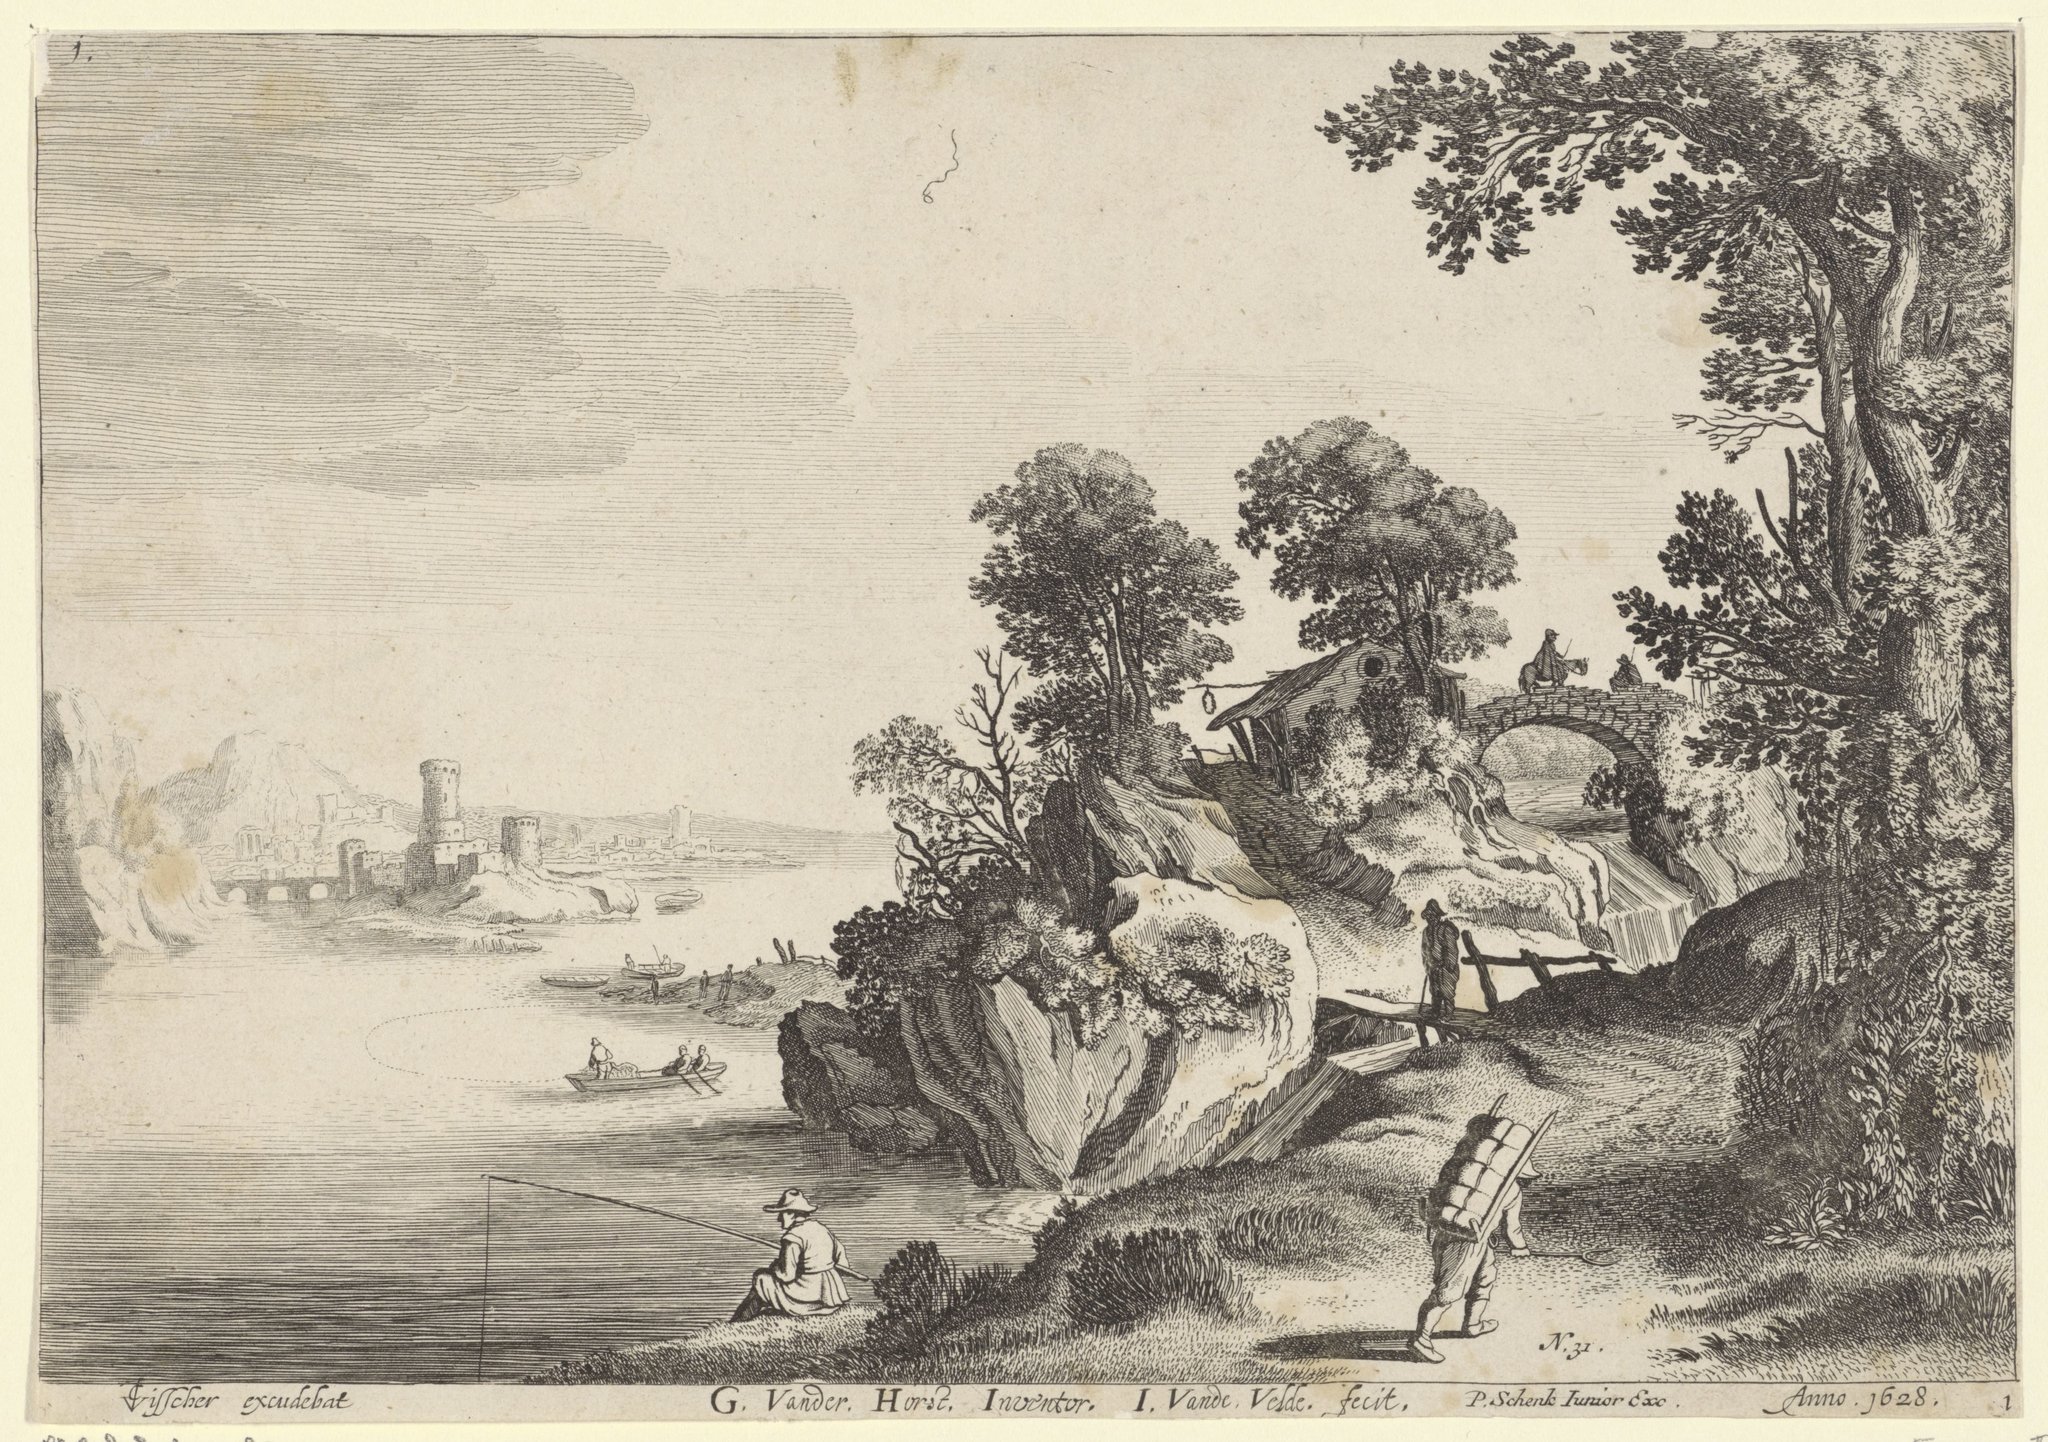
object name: print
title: Landschappen naar Gerrit van der Horst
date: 1628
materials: paper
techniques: etching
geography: northern netherlands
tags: river, 'en route', traveller under way, angling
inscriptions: collector's mark: Lugt 964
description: Claes Jansz. Visscher (II) heeft een zesde prent, gemaakt door hemzelf en tevens naar ontwerp van Gerrit van der Horst, aan de serie toegevoegd. Franken & Van der Kellen noemt deze prent de zesde prent van deze serie, Hollstein noemt deze zesde prent maar voegt hem niet toe aan de serie van Van de Velde (II).